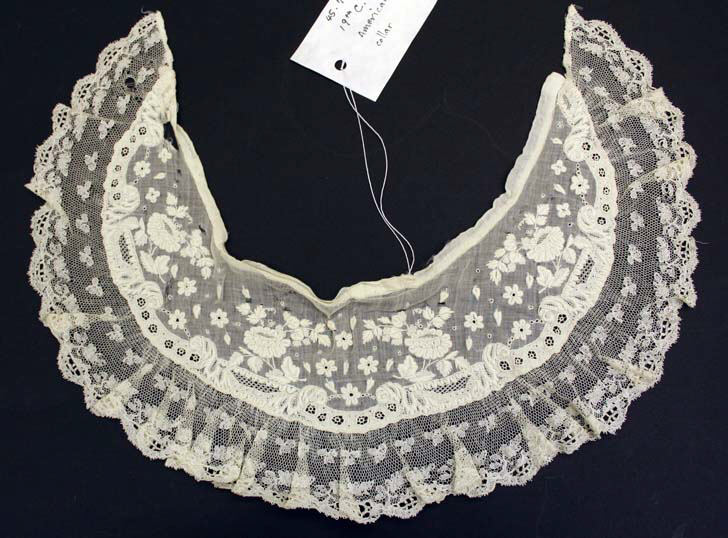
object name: collar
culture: american or european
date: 1700-1945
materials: cotton